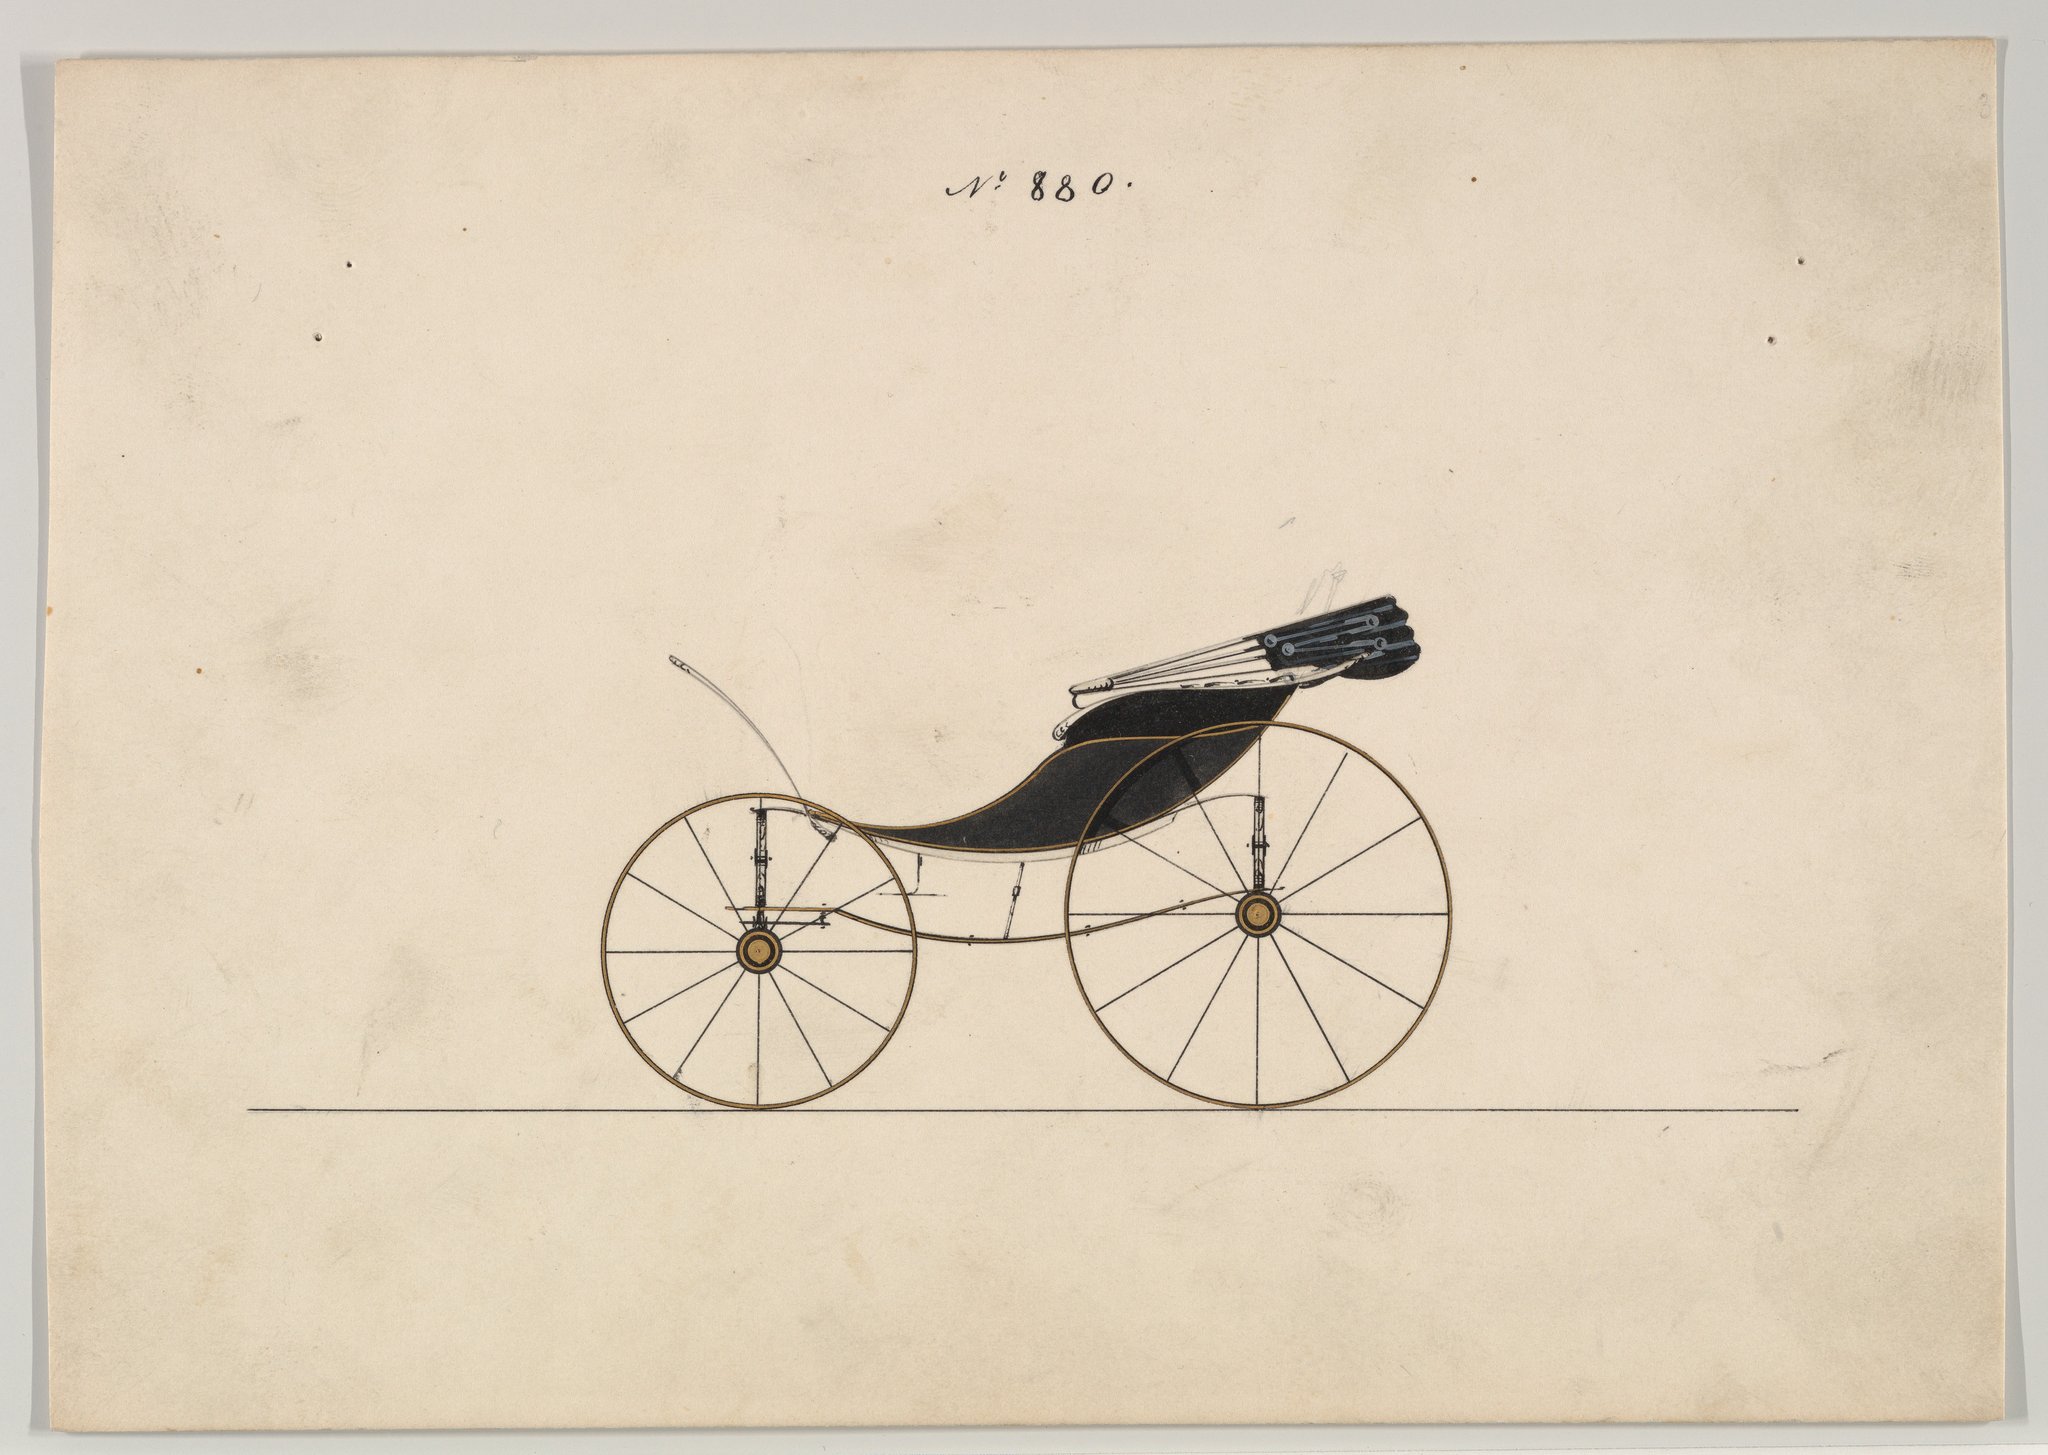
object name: drawing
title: Phaeton #880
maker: brewster & co.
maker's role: manufacturer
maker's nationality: american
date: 1865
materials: gouache, gum arabic, ink, watercolor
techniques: pen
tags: carriages